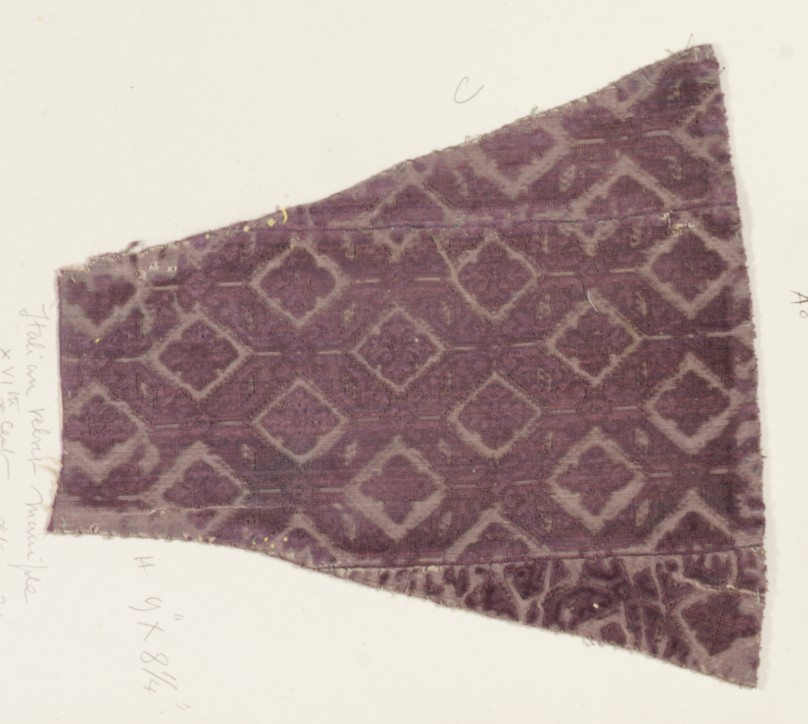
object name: fragment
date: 1501-1600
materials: silk